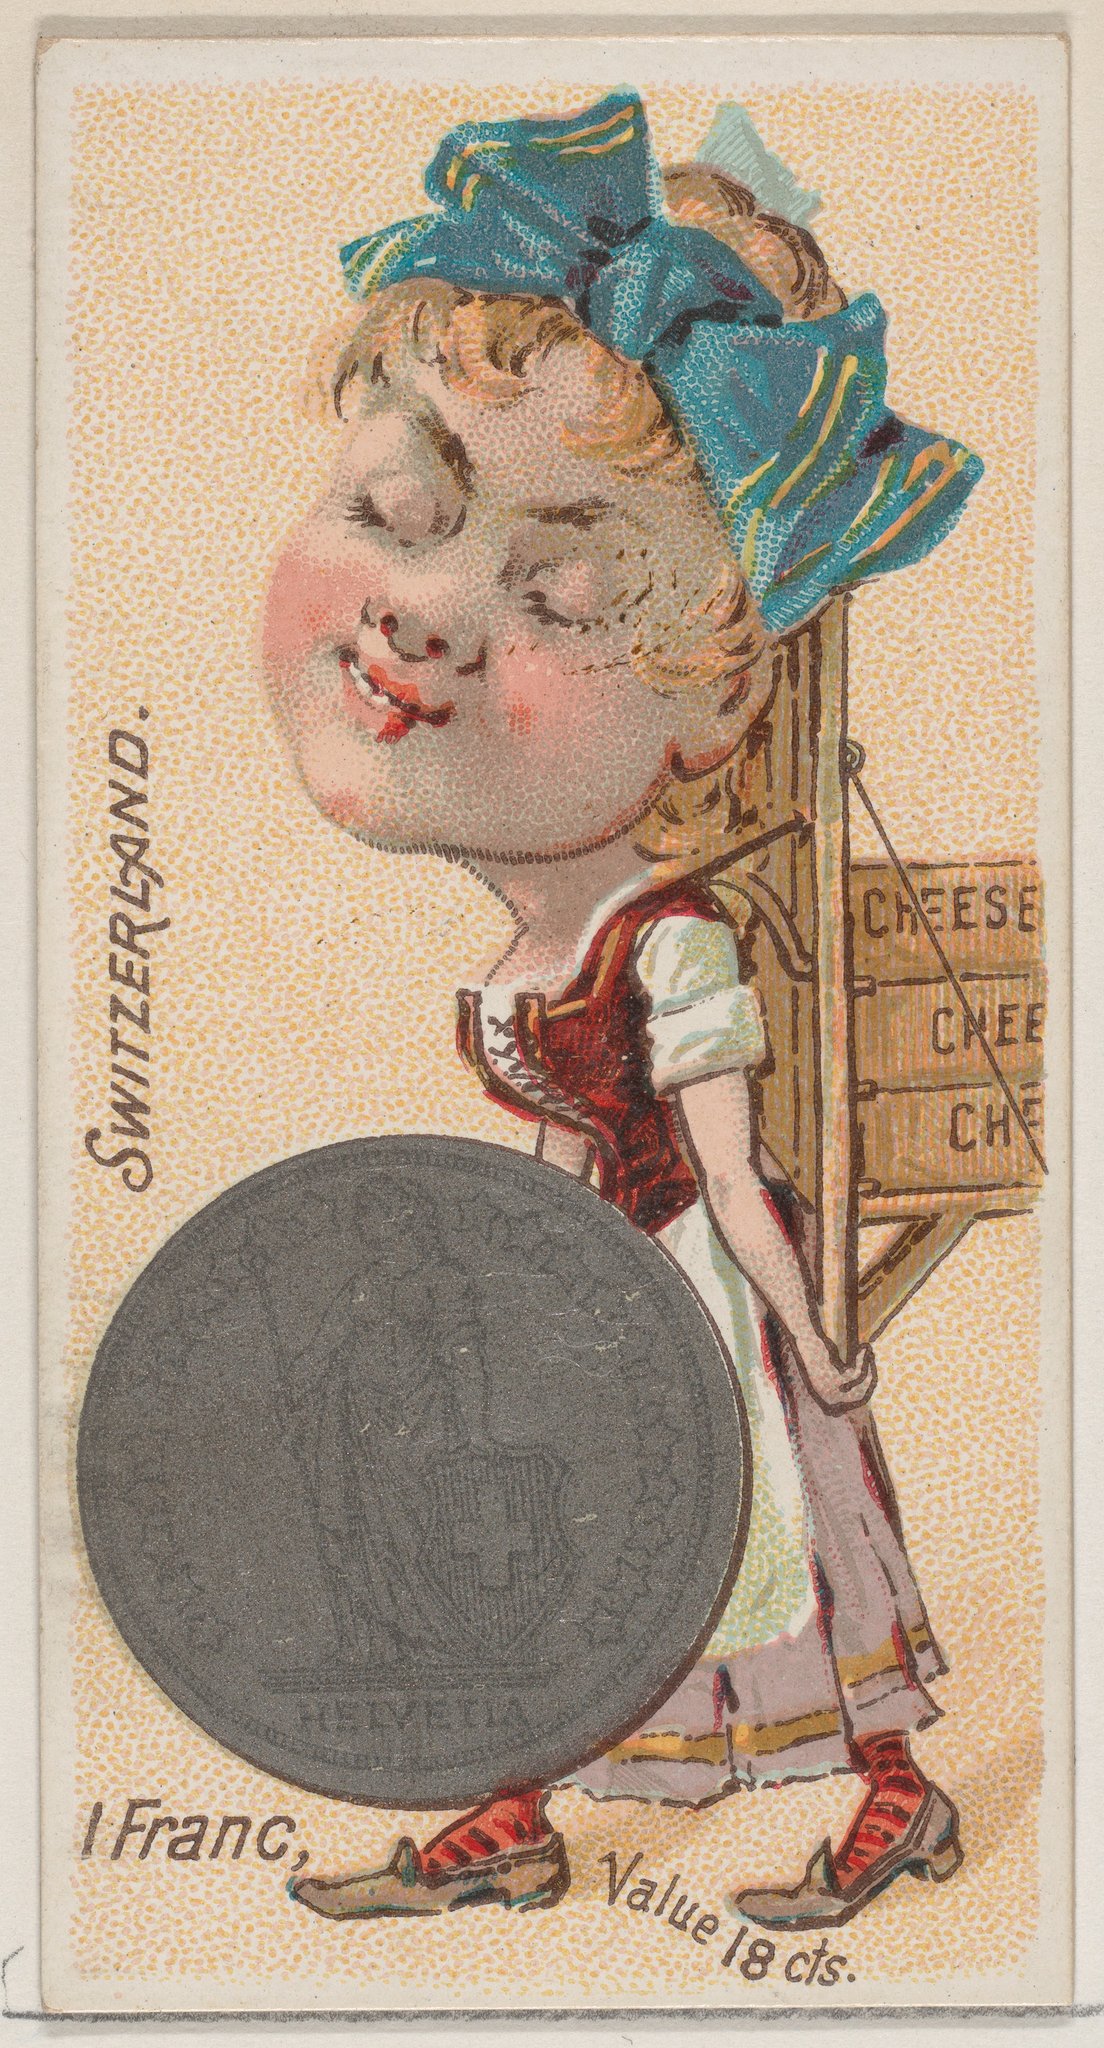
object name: print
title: Switzerland, 1 Franc, from the series Coins of All Nations (N72, variation 2) for Duke brand cigarettes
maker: w. duke, sons & co.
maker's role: publisher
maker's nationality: american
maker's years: 1870-1920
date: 1889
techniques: color lithograph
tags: women,coins